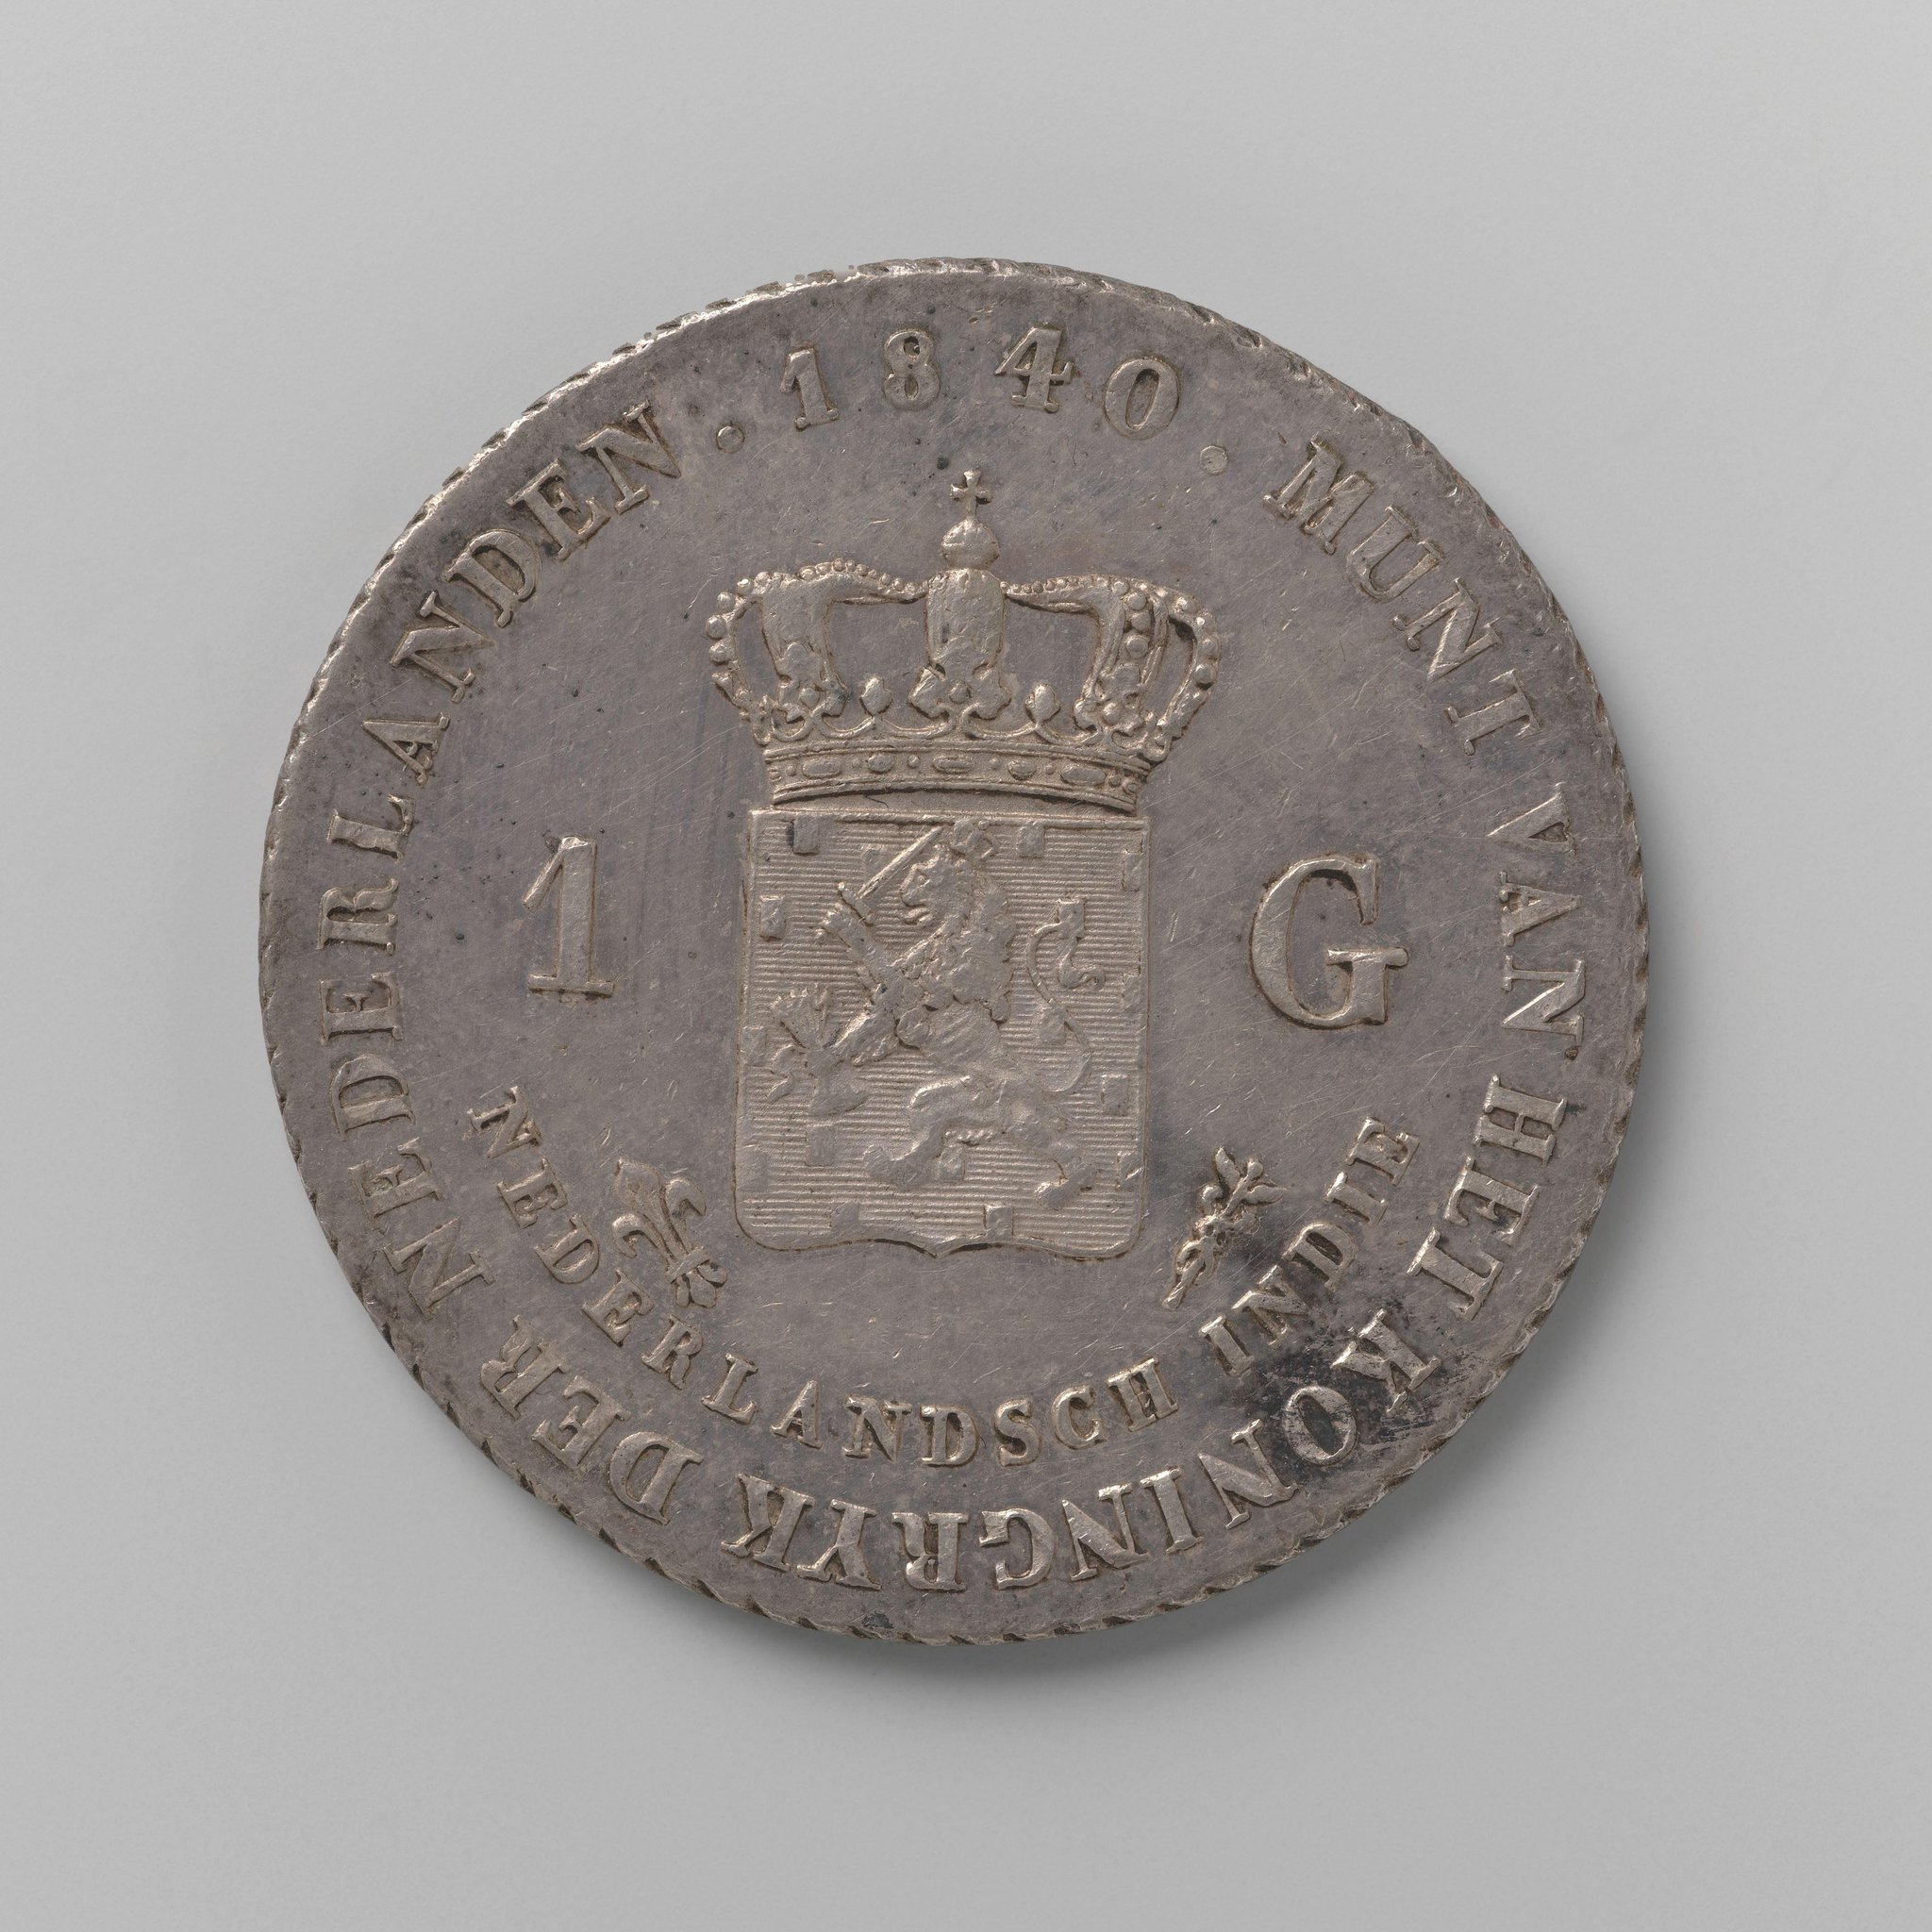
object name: coin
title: Nederlands Indië, gulden, 1840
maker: william i of the netherlands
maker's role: koning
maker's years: 1772-1843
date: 1840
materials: silver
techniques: striking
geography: utrecht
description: Zilveren munt. Voorzijde: borstbeeld naar rechts. Keerzijde: tussen waarde-aanduiding 1 G gekroond rijkswapenschild. Onder het wapenschild in gebogen lijn lands-aanduiding: Nederlandsch Indië. Jaartal boven kroon. Kabelrand.